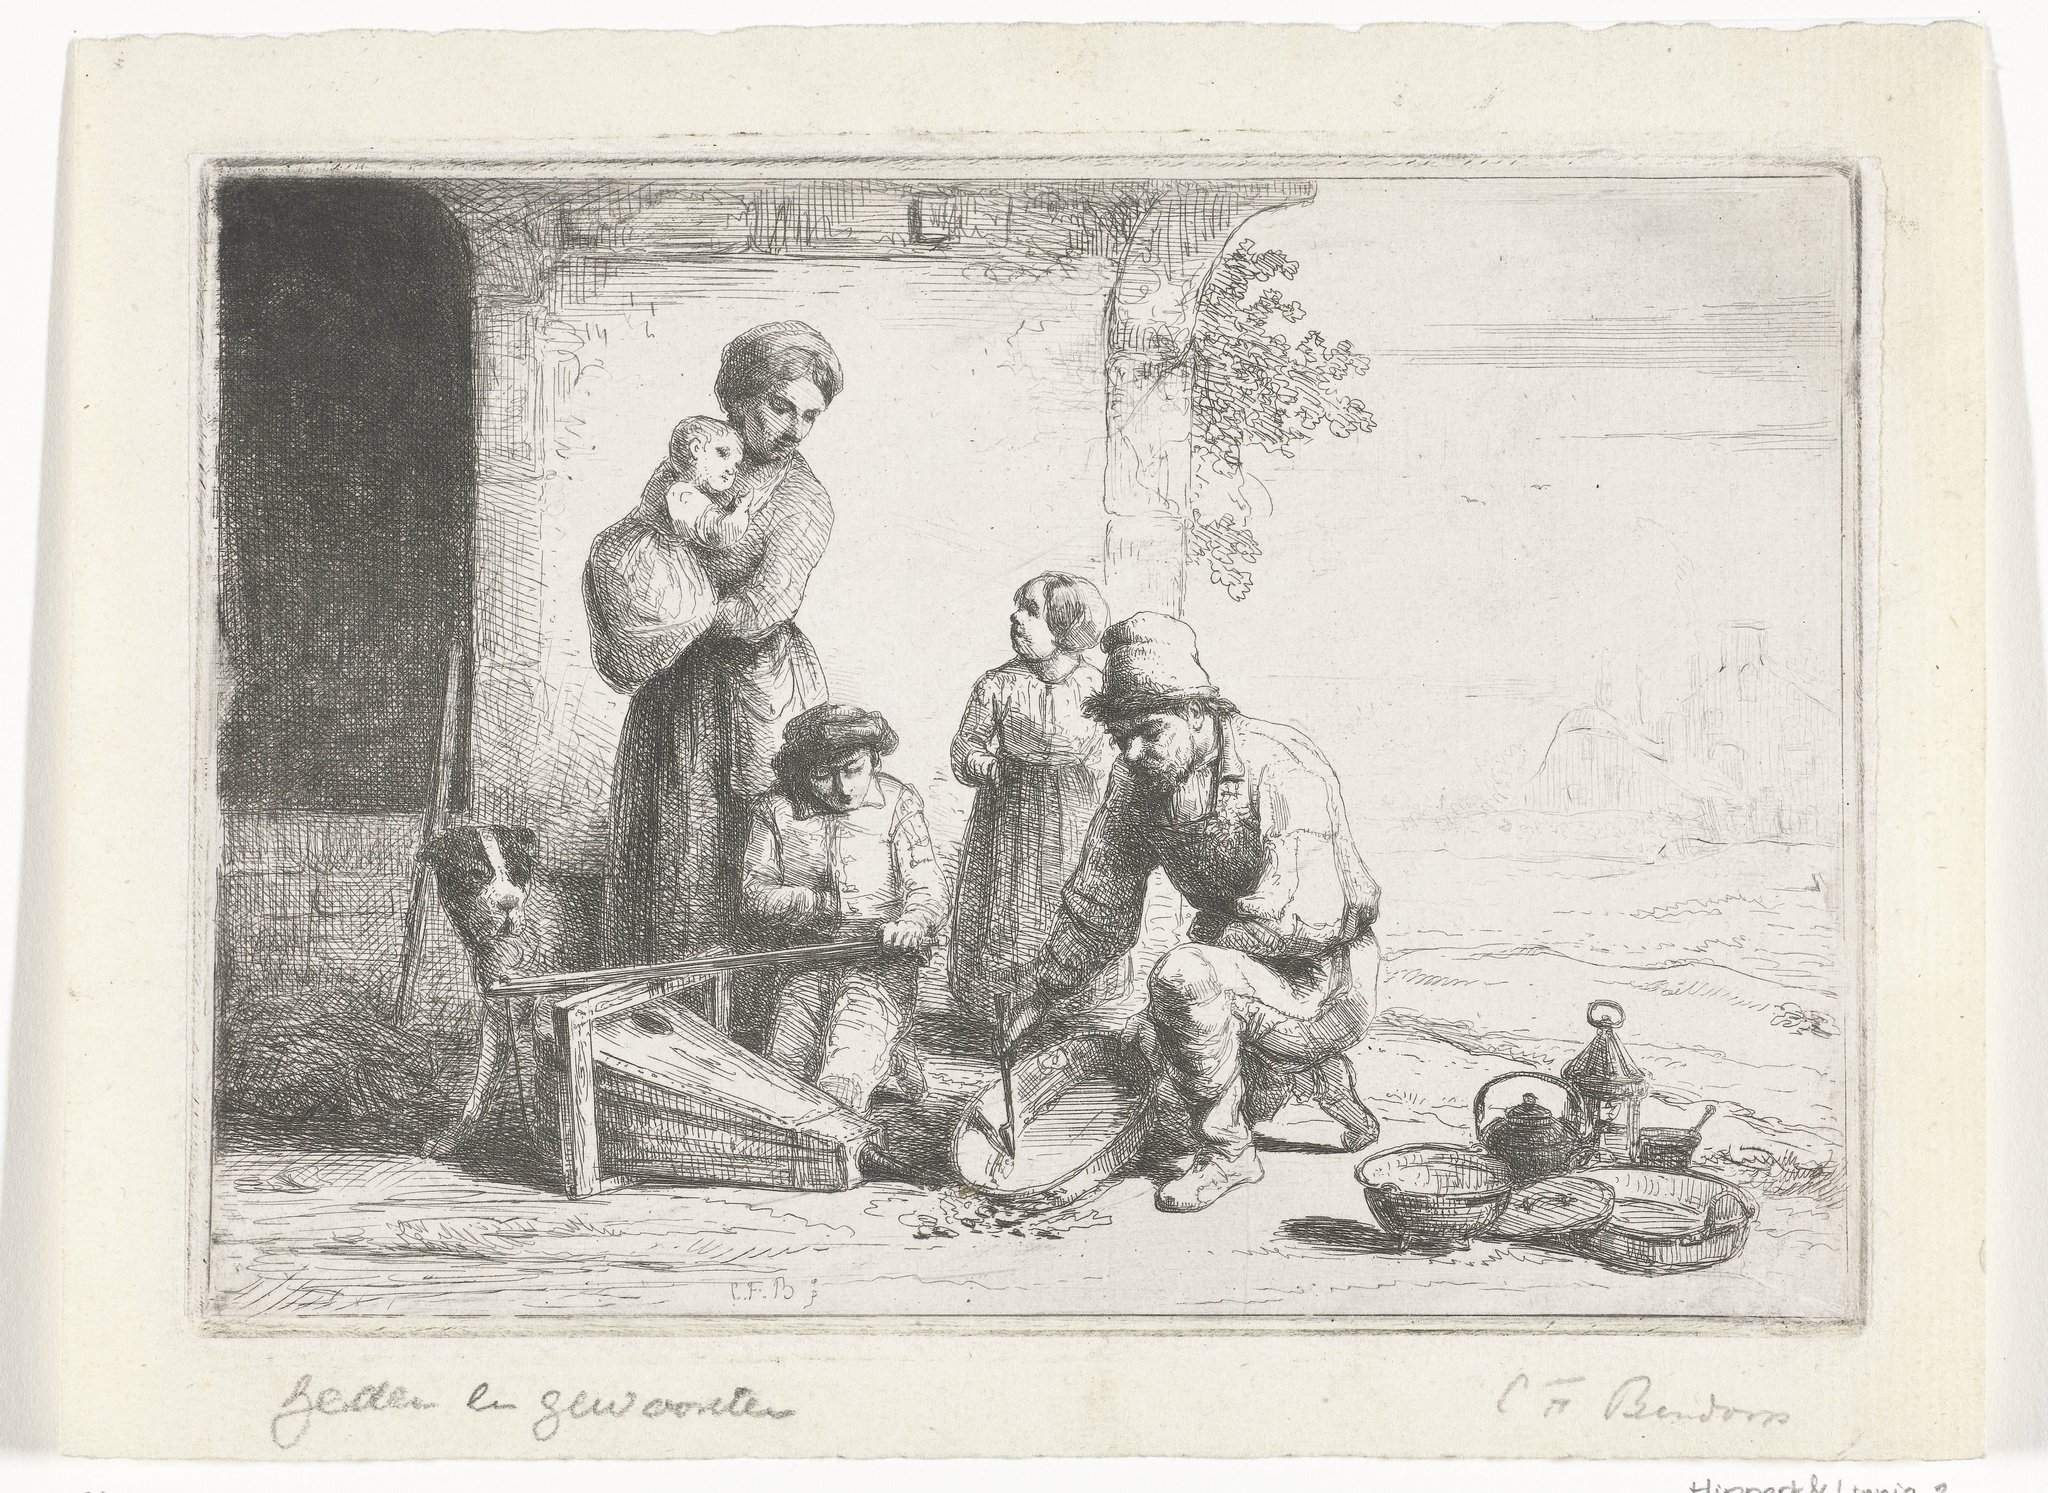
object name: print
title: Ketellapper herstelt bak en vrouw en kinderen kijken toe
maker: carel frederik bendorp (ii)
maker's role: draughtsman, painter, print maker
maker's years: 1819-1897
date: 1829-1897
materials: paper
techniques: etching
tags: family group, especially parents with their child(ren), mother and baby or young child, other handicrafts ~ metal (with name of trade or profession)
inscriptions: collector's mark: Lugt 2233, collector's mark: Lugt 689